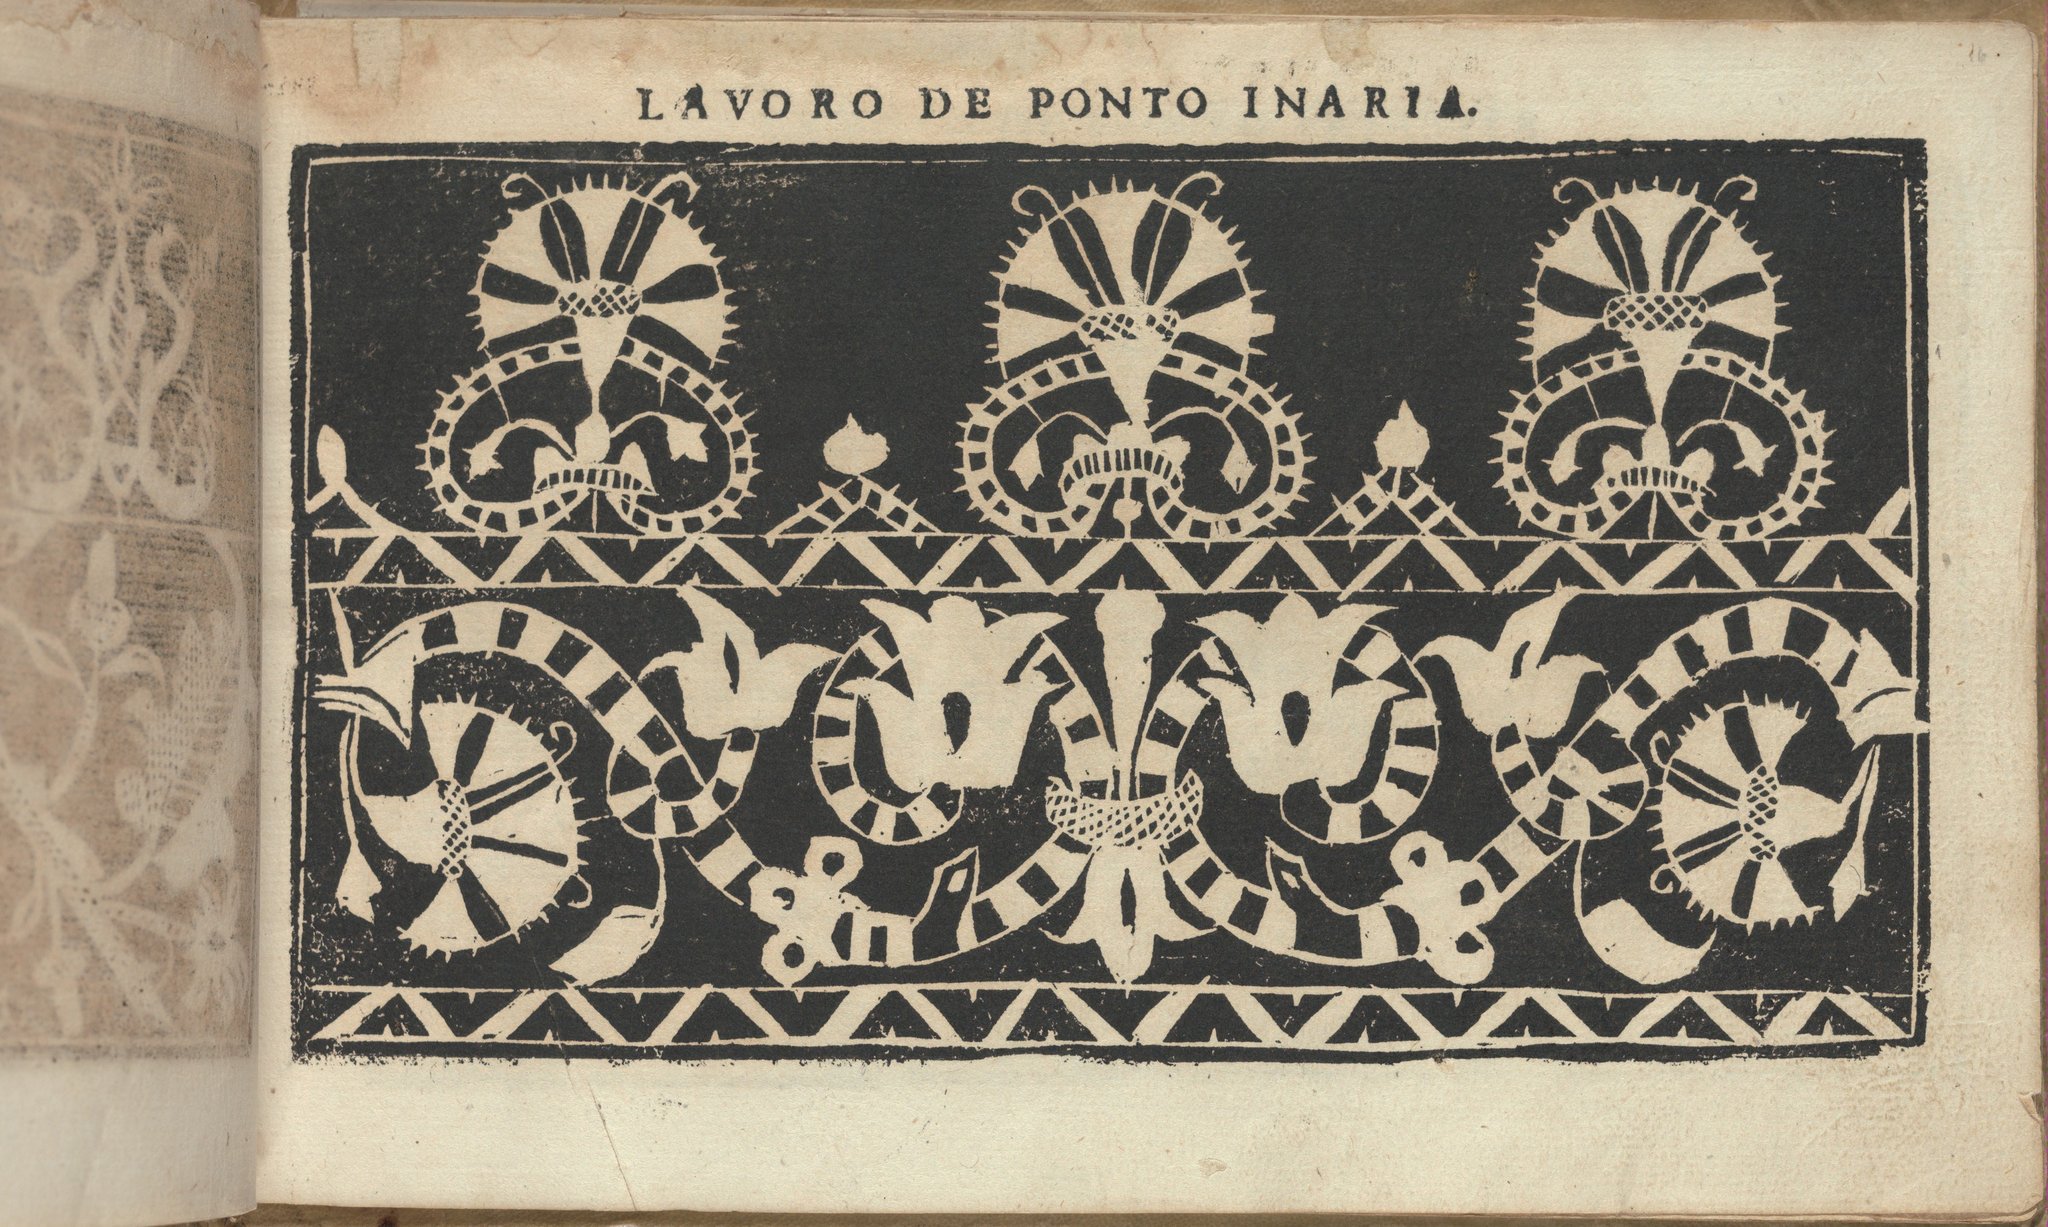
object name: book print ornament architecture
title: Studio delle virtuose Dame, page 16 (recto)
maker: isabella catanea parasole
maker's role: designer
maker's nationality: italian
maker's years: 1565-1625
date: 1597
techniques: woodcut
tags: flowers